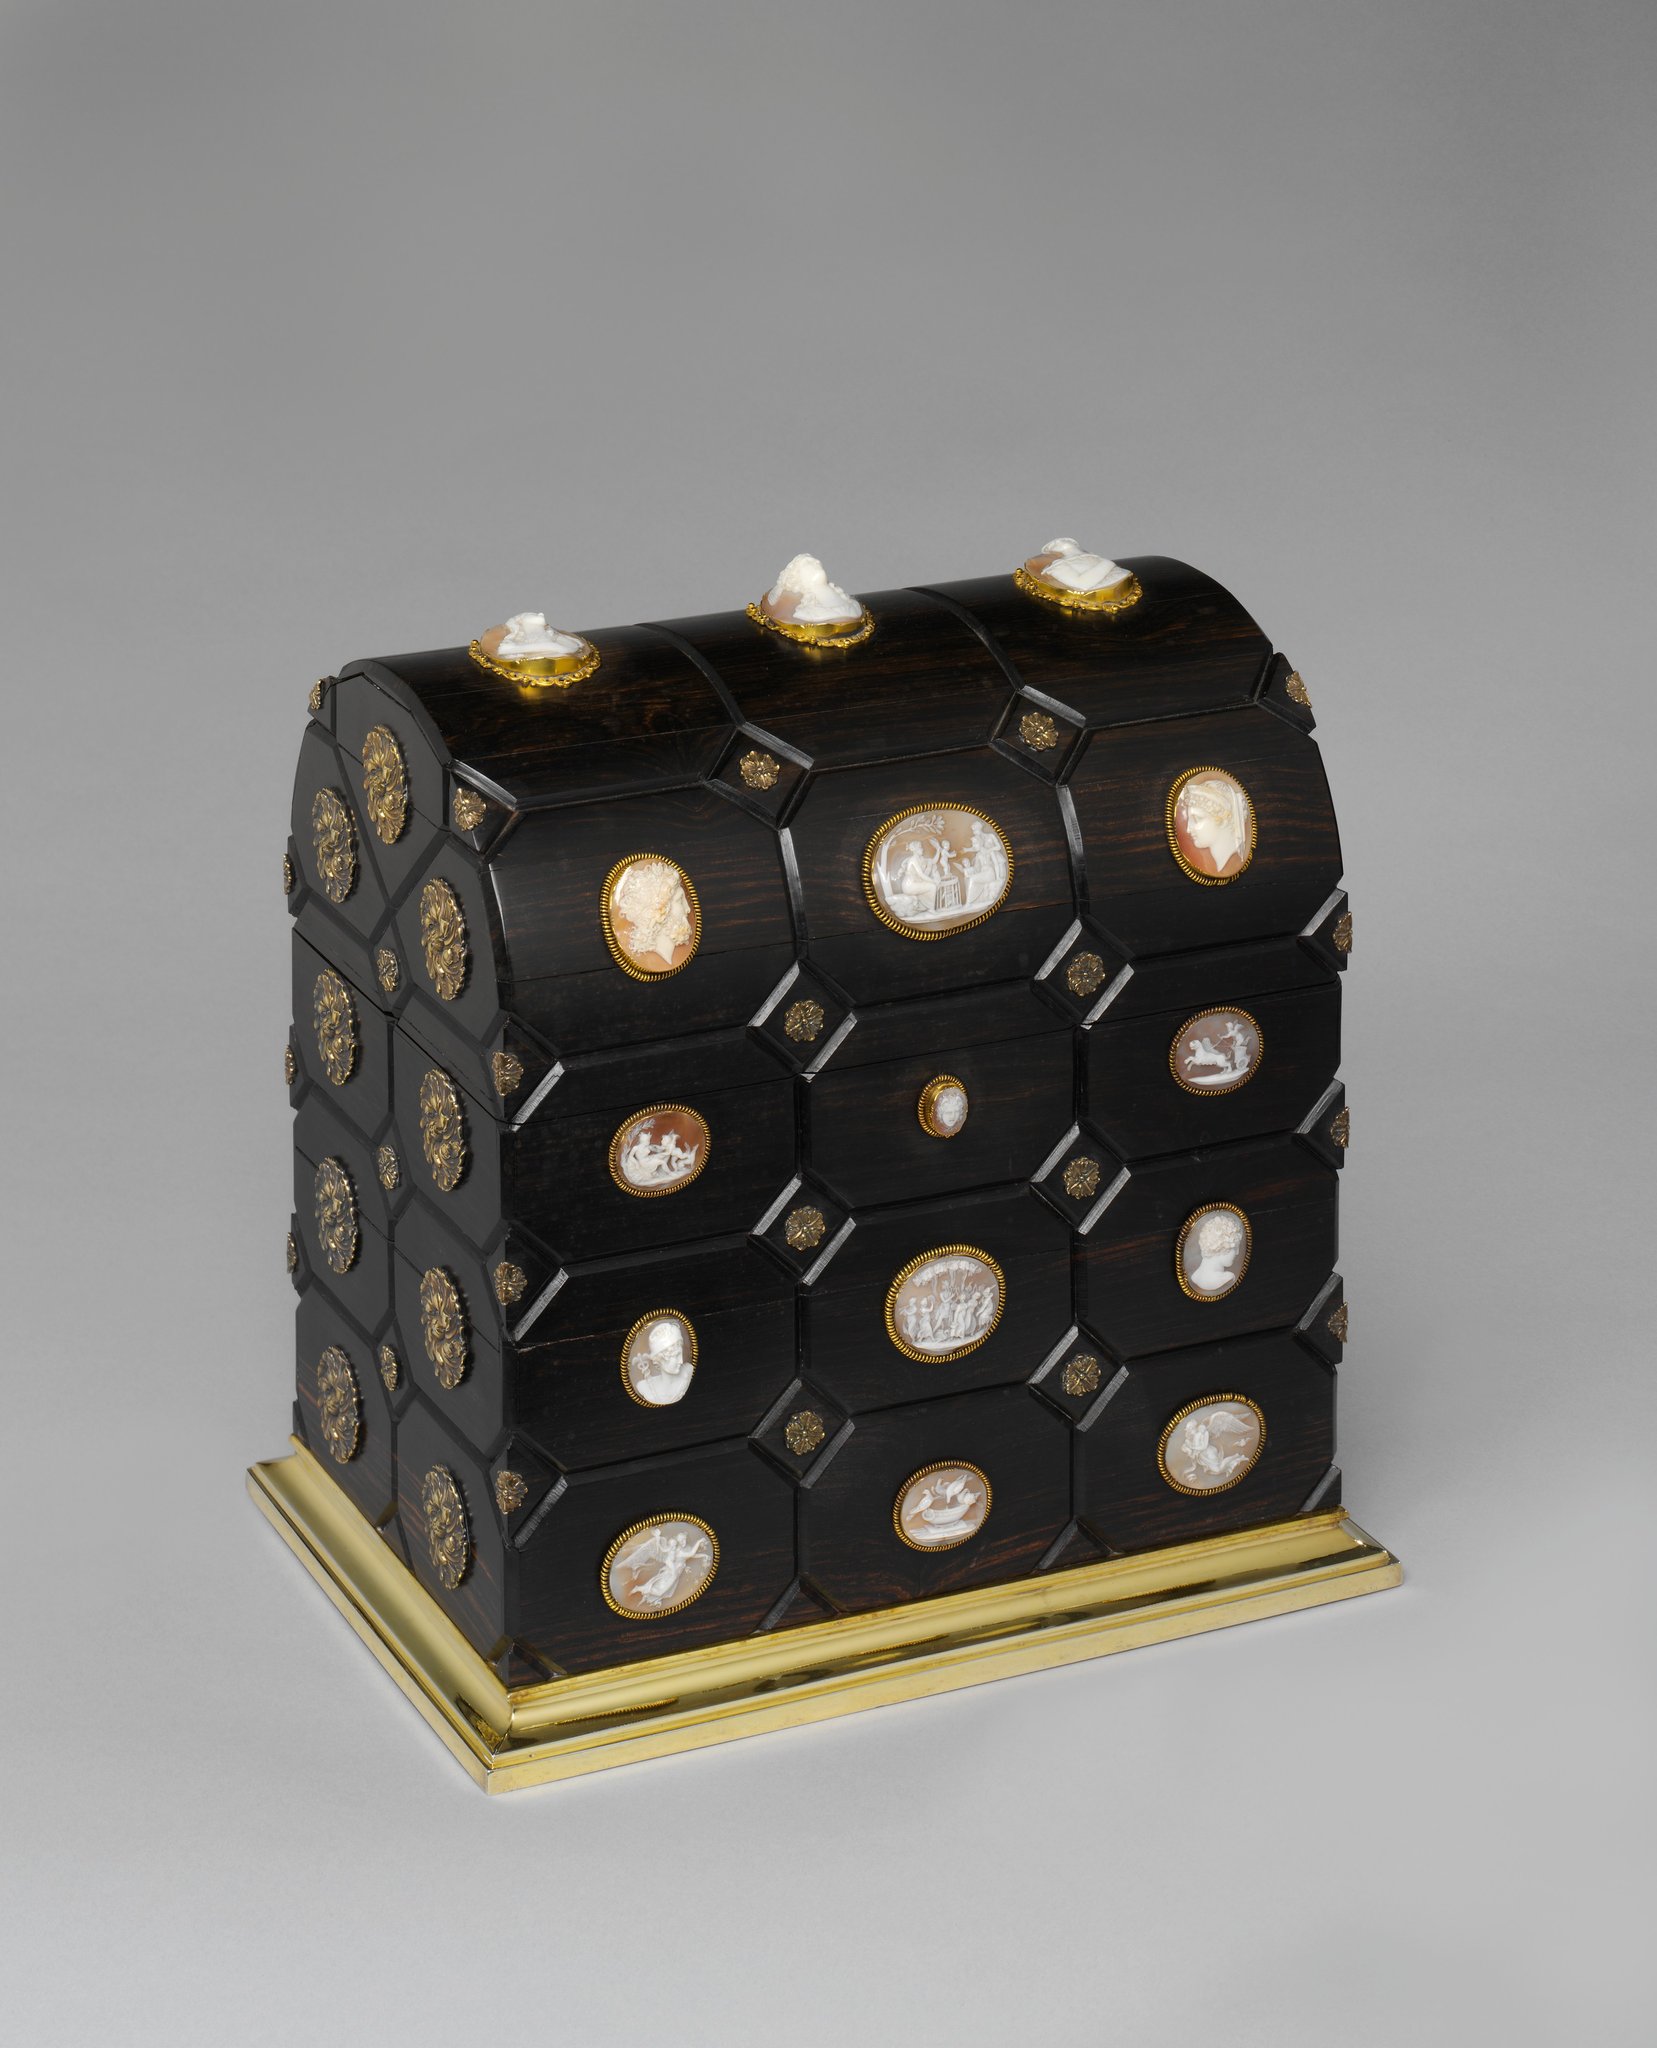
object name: casket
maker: r. & s. garrard & co.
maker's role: maker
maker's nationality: british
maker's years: 1735-1900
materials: wood, shell, silver gilt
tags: men,women